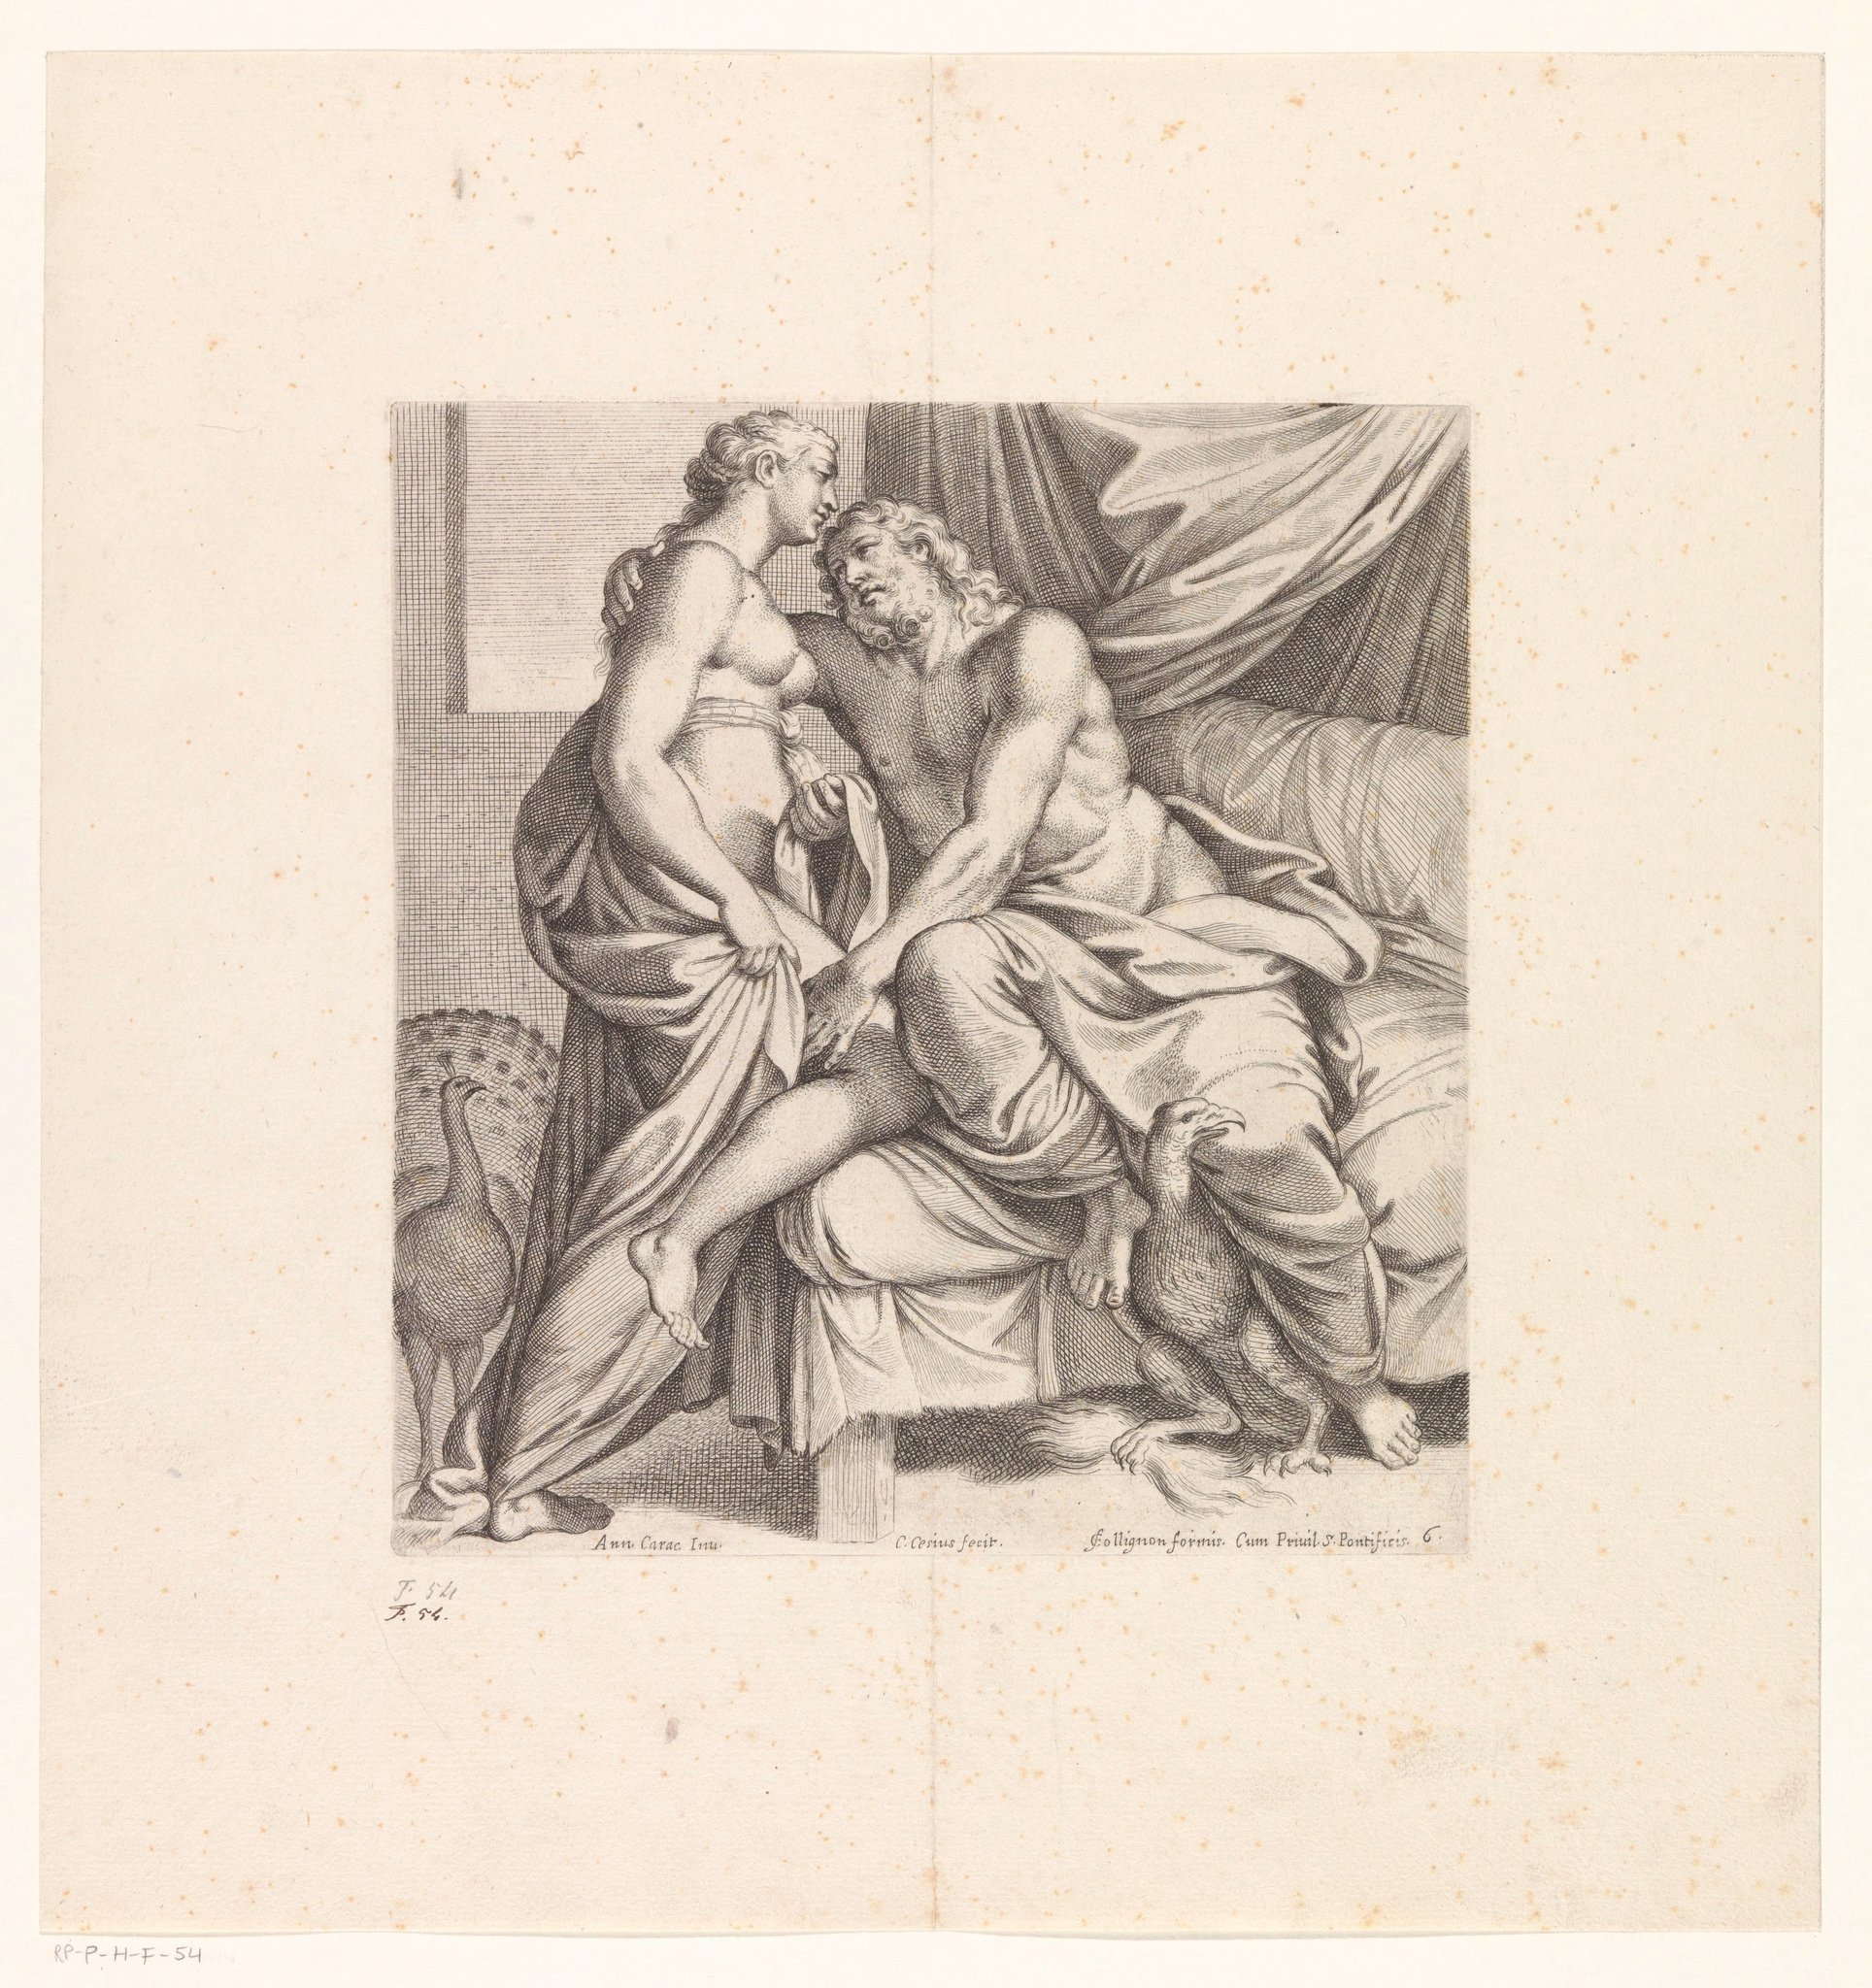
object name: print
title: Schilderingen in Palazzo Farnese te Rome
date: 1656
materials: paper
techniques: etching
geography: vatican city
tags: jupiter and juno as lovers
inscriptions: collector's mark: ‘Hinloopen’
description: Prent uit een reeks prenten met nummers van 1 tot en met 29 (sommige prenten hebben hetzelfde nummer), plus titelprent en opdracht, naar schilderingen in Palazzo Farnese te Rome. Deze prent maakte oorspronkelijk deel uit van liber nr. 22 van de Atlas van Rome, uit de collectie Hinloopen. In dit album waren een aantal prentreeksen naar bekende zeventiende eeuwse frescoseries bijeengebonden. In 1709 heeft Schijnvoet op last van de burgemeesters van Amsterdam de collectie herordend. De prenten uit liber 22 kwamen terrecht in Schijnvoet boek nr. 10. De laatst gedateerde reeks in het album is gedateerd 1691. Het album moet dus na deze datum gebonden zijn. De band is in de Rijksakademietijd uit elkaar gehaald. De marges van de prenten zijn bij het opbergen in het Rijksprentenkabinet vaak drastisch afgesneden. Van een aantal series waren de prenten teruggeslagen om in het album te passen. (Zie: Waals, Jan van der. De prentschat van Michiel Hinloopen. 's-Gravenhage: SDU uitgeverij, 1988, pp. 173-174.)